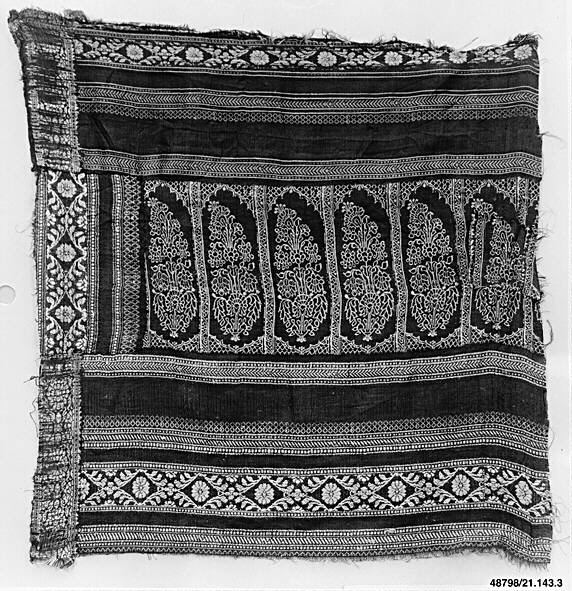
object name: sari fragment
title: Fragment of Sari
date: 1801-1900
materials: silk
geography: india